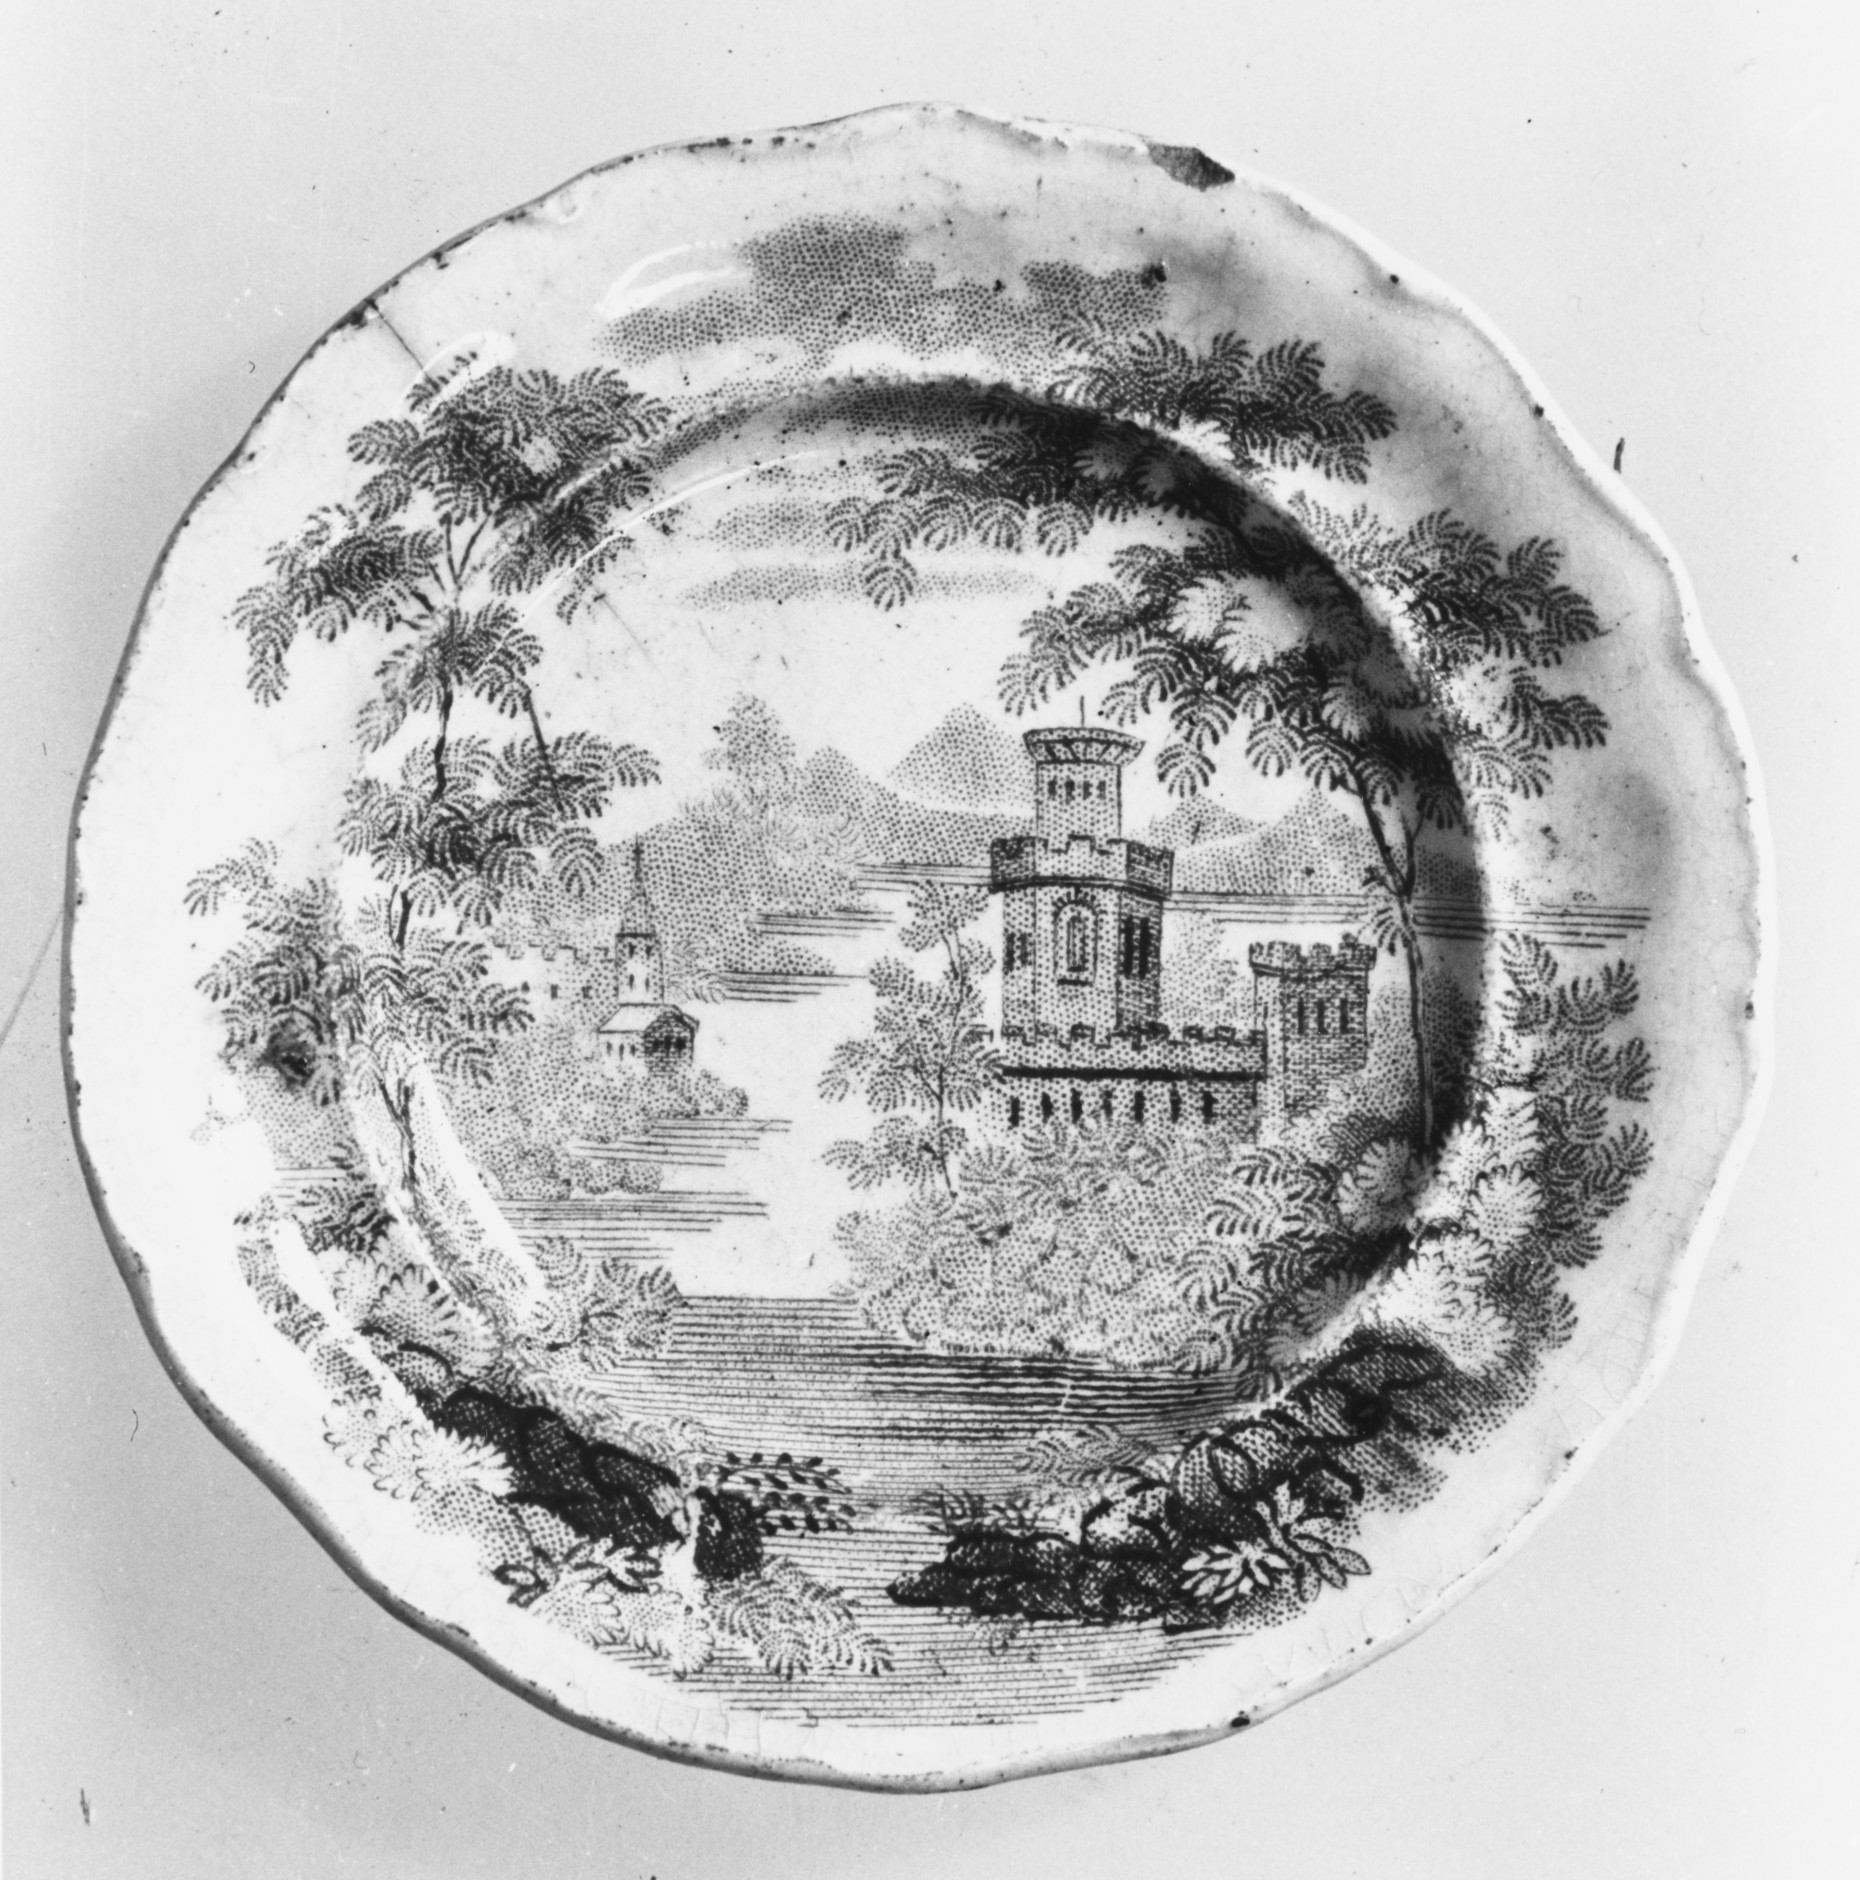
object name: plate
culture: british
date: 1830-1870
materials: earthenware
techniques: transfer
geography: england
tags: castles,landscapes